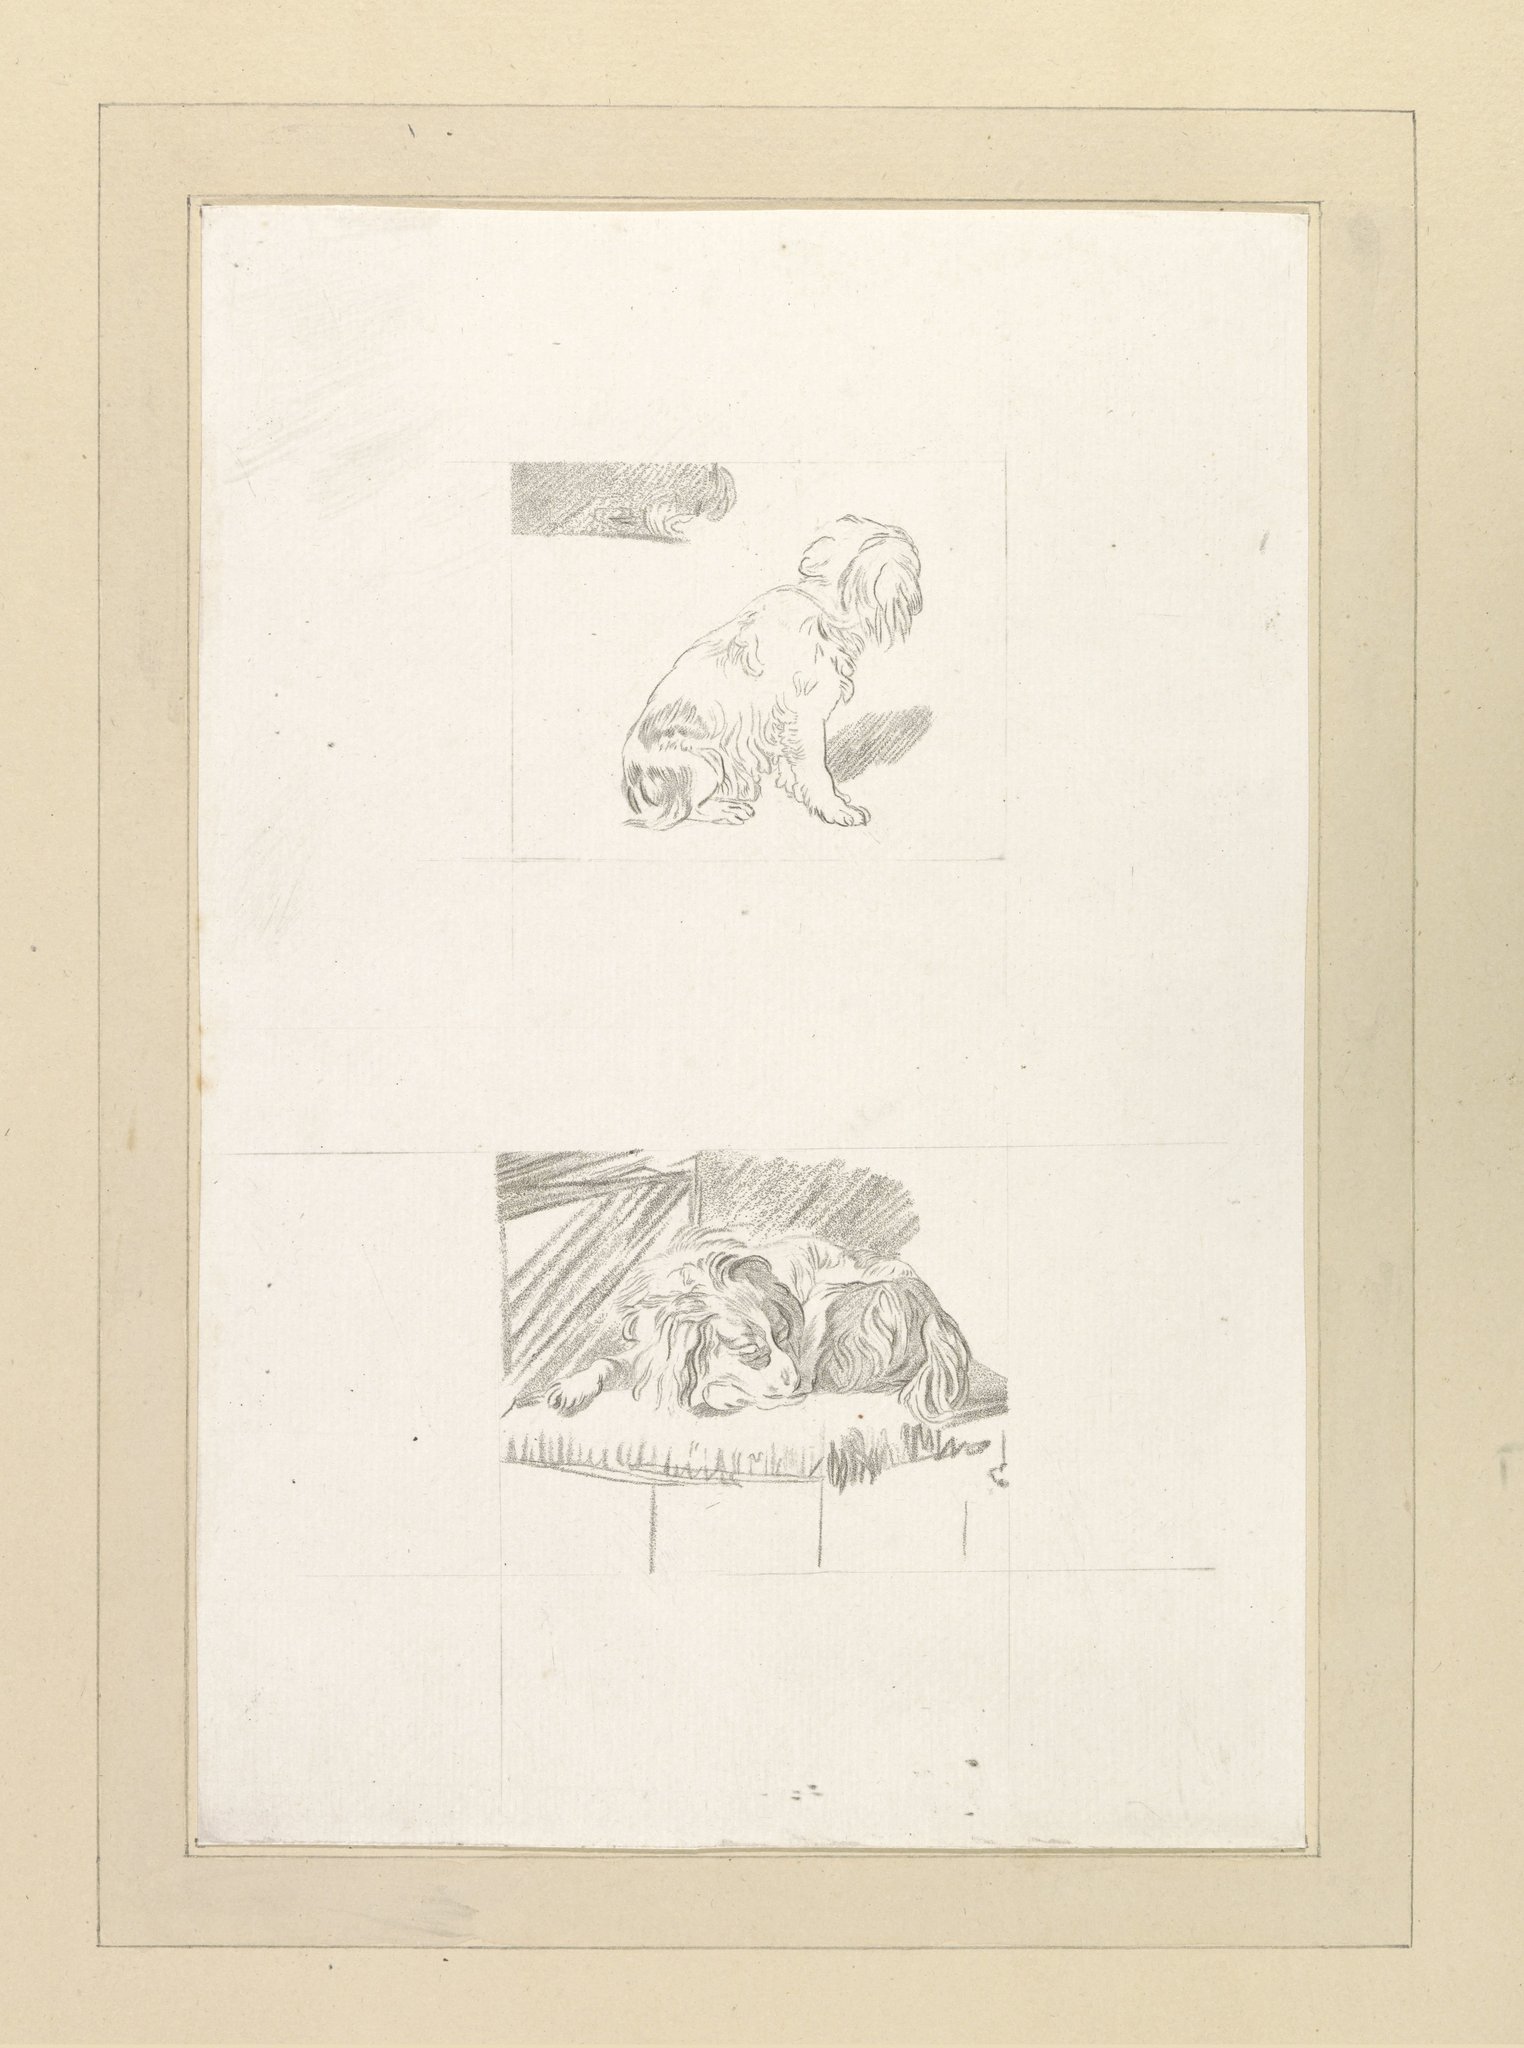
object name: print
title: Zittende en liggende hond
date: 1777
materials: paper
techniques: printmaking, etching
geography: amsterdam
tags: dog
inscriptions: collector's mark: Lugt 2228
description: Twee voorstellingen op een blad. Boven een zittende hond. Onder een liggende hond.